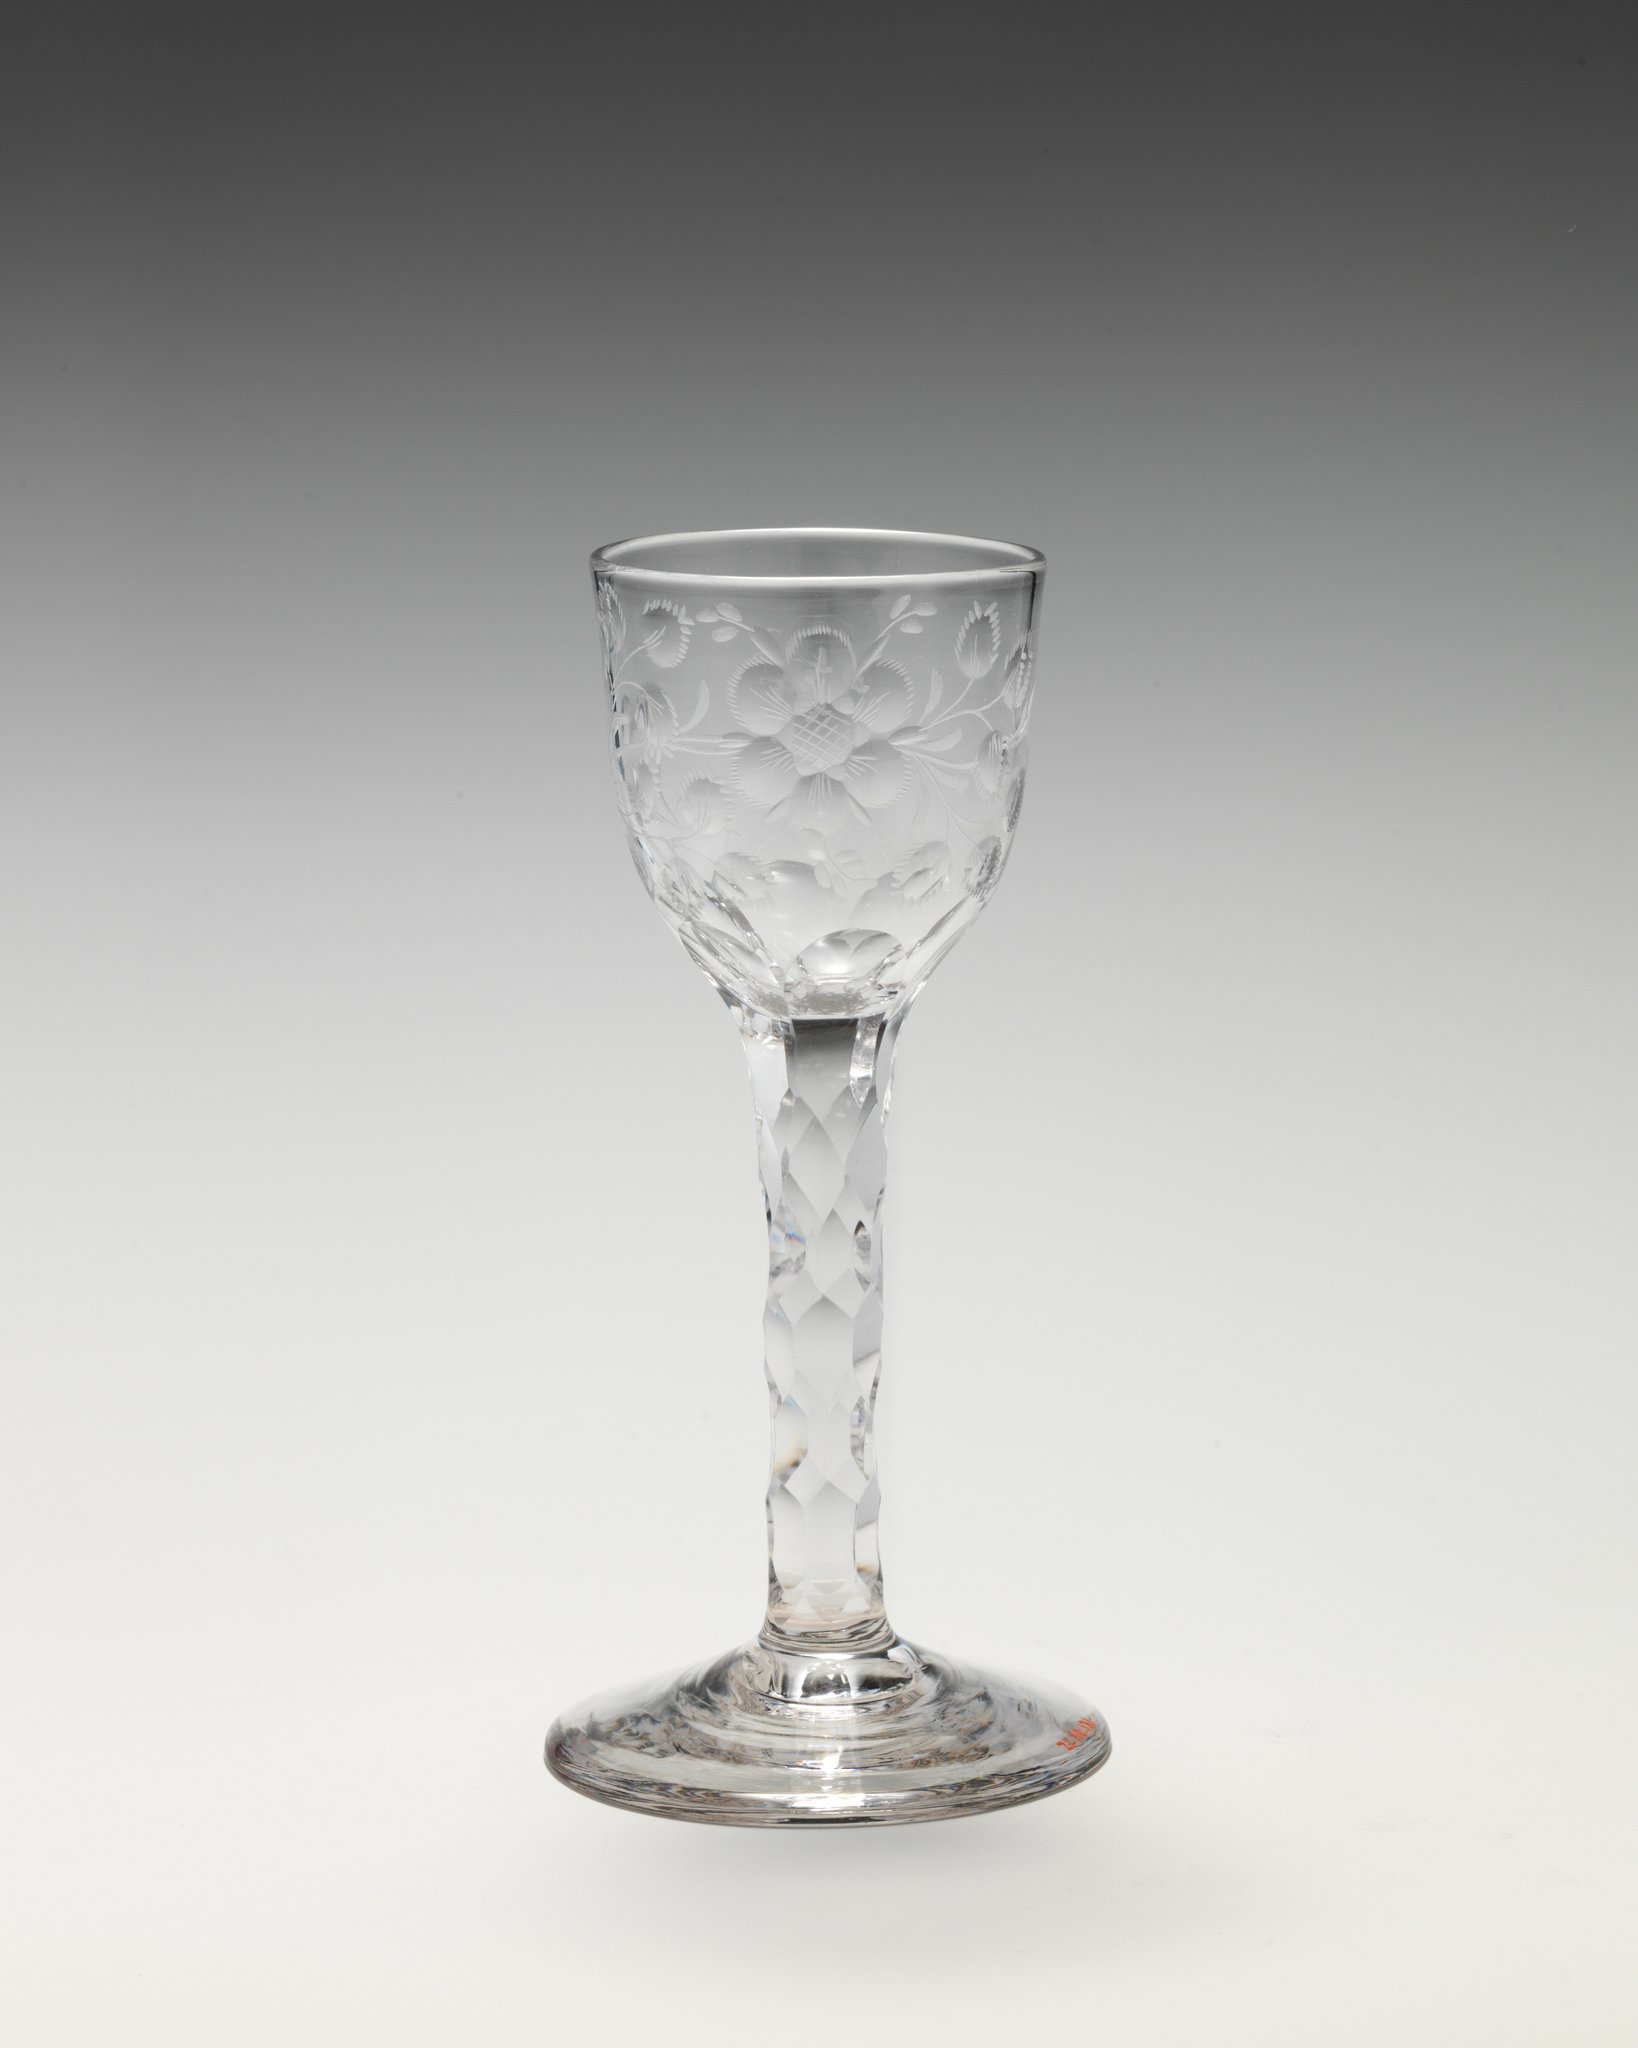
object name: wineglass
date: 1780-1800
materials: glass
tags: flowers